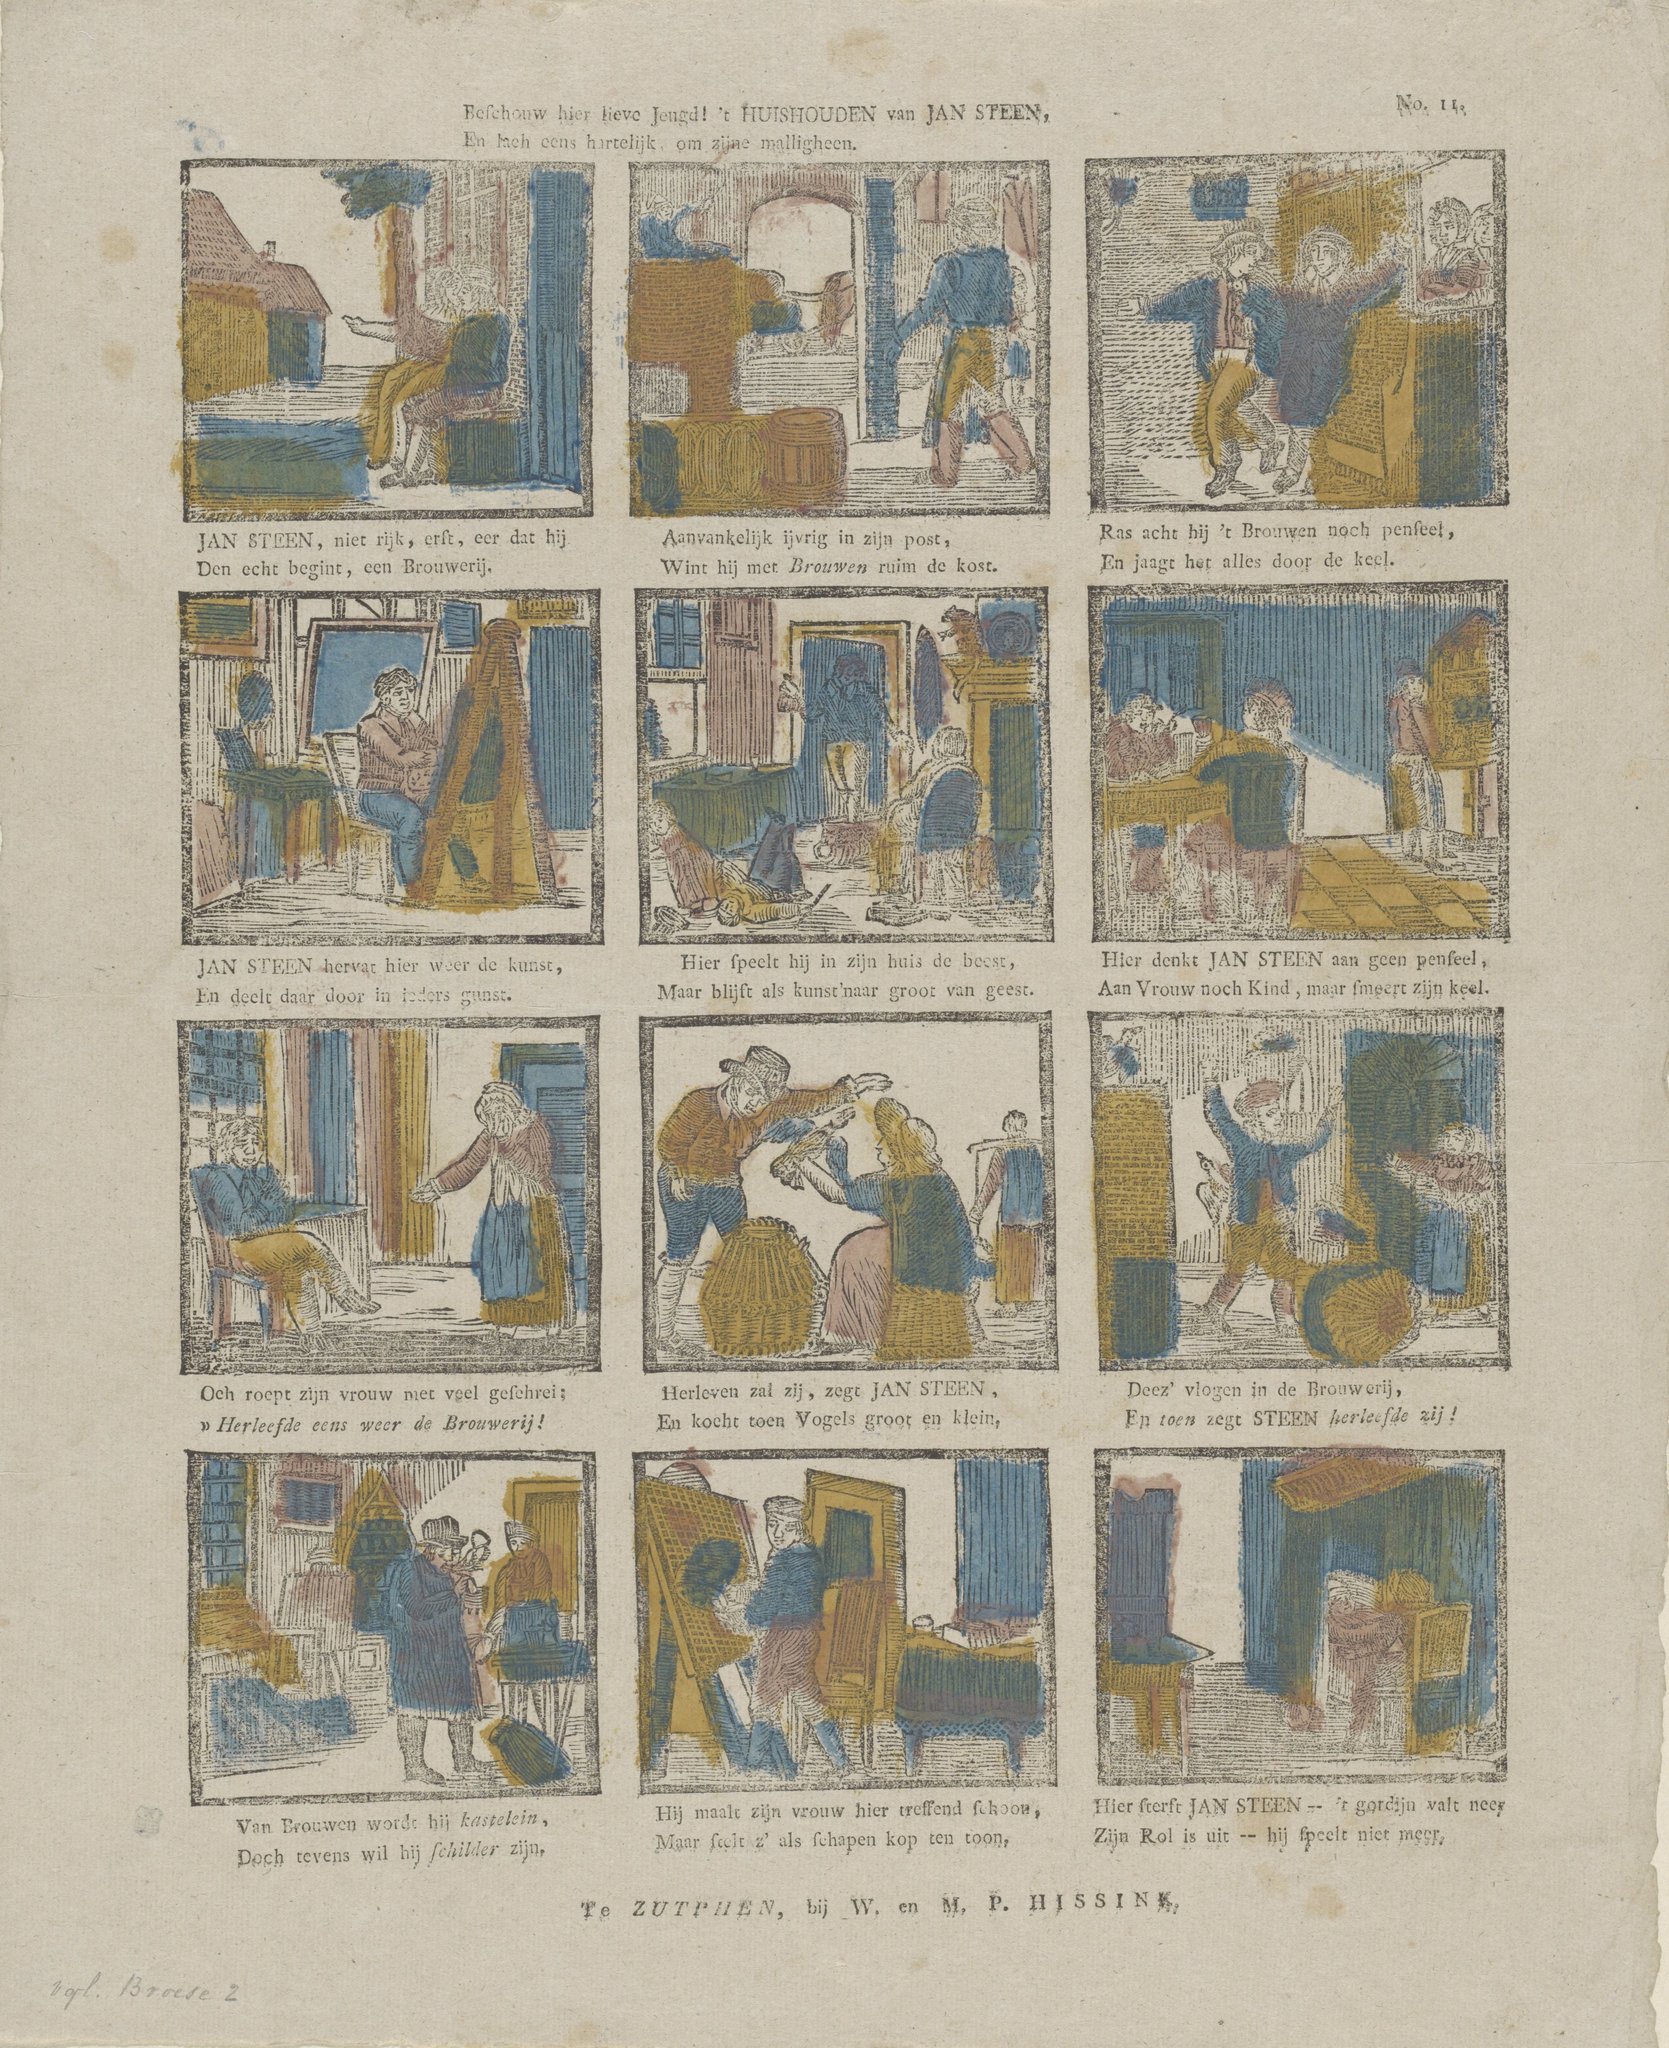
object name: print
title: Beschouw hier lieve jeugd! 't huishouden van Jan Steen, / En lach eens hartelijk, om zijn malligheen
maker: Anonymous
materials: paper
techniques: colour, letterpress printing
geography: amsterdam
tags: a perfect shambles (dutch: 'huishouden van jan steen')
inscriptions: collector's mark: Lugt 2760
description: Blad met 12 voorstellingen over het huishouden van Jan Steen. Jan schildert, heeft een brouwerij, koopt eenden en sterft. Onder elke voorstelling een tweeregelig vers. Genummerd rechtsboven: No. 11.